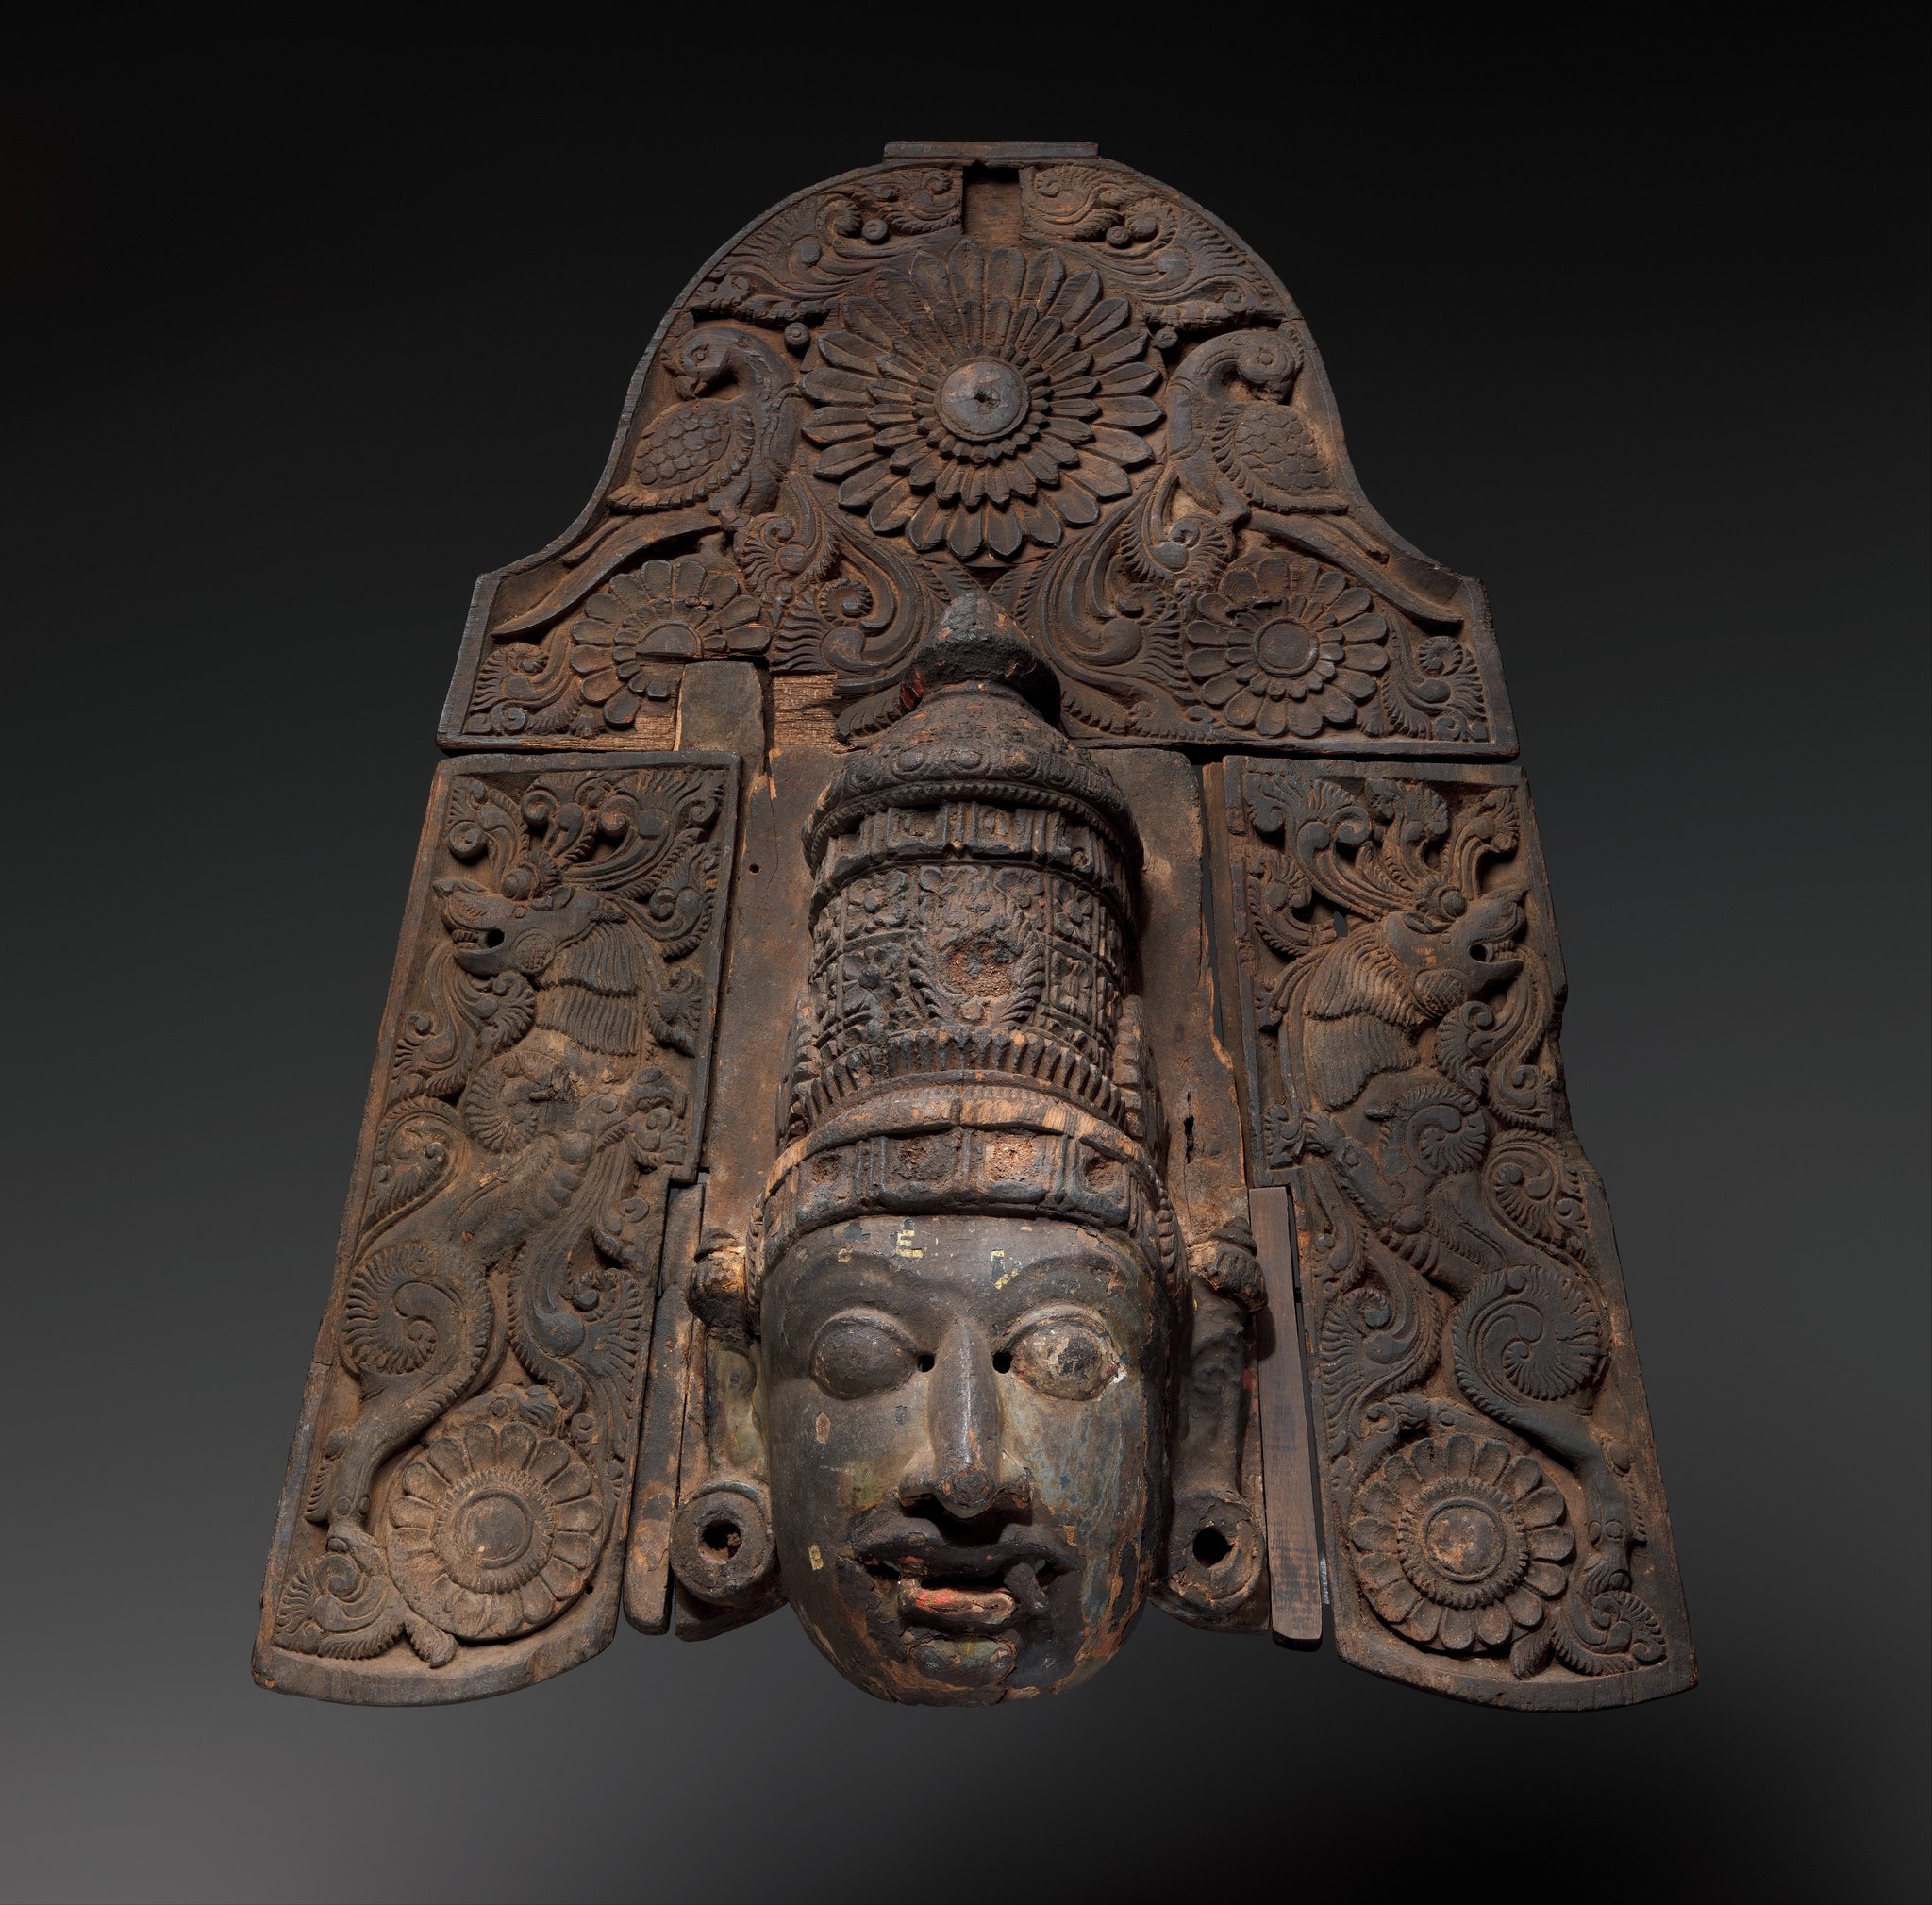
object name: mask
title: Hiranyakashipu, The Demon-King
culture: indian, southern, tamil nadu, thanjavur district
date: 1700-1750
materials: textile, wood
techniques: polychrome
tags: parrots,demons